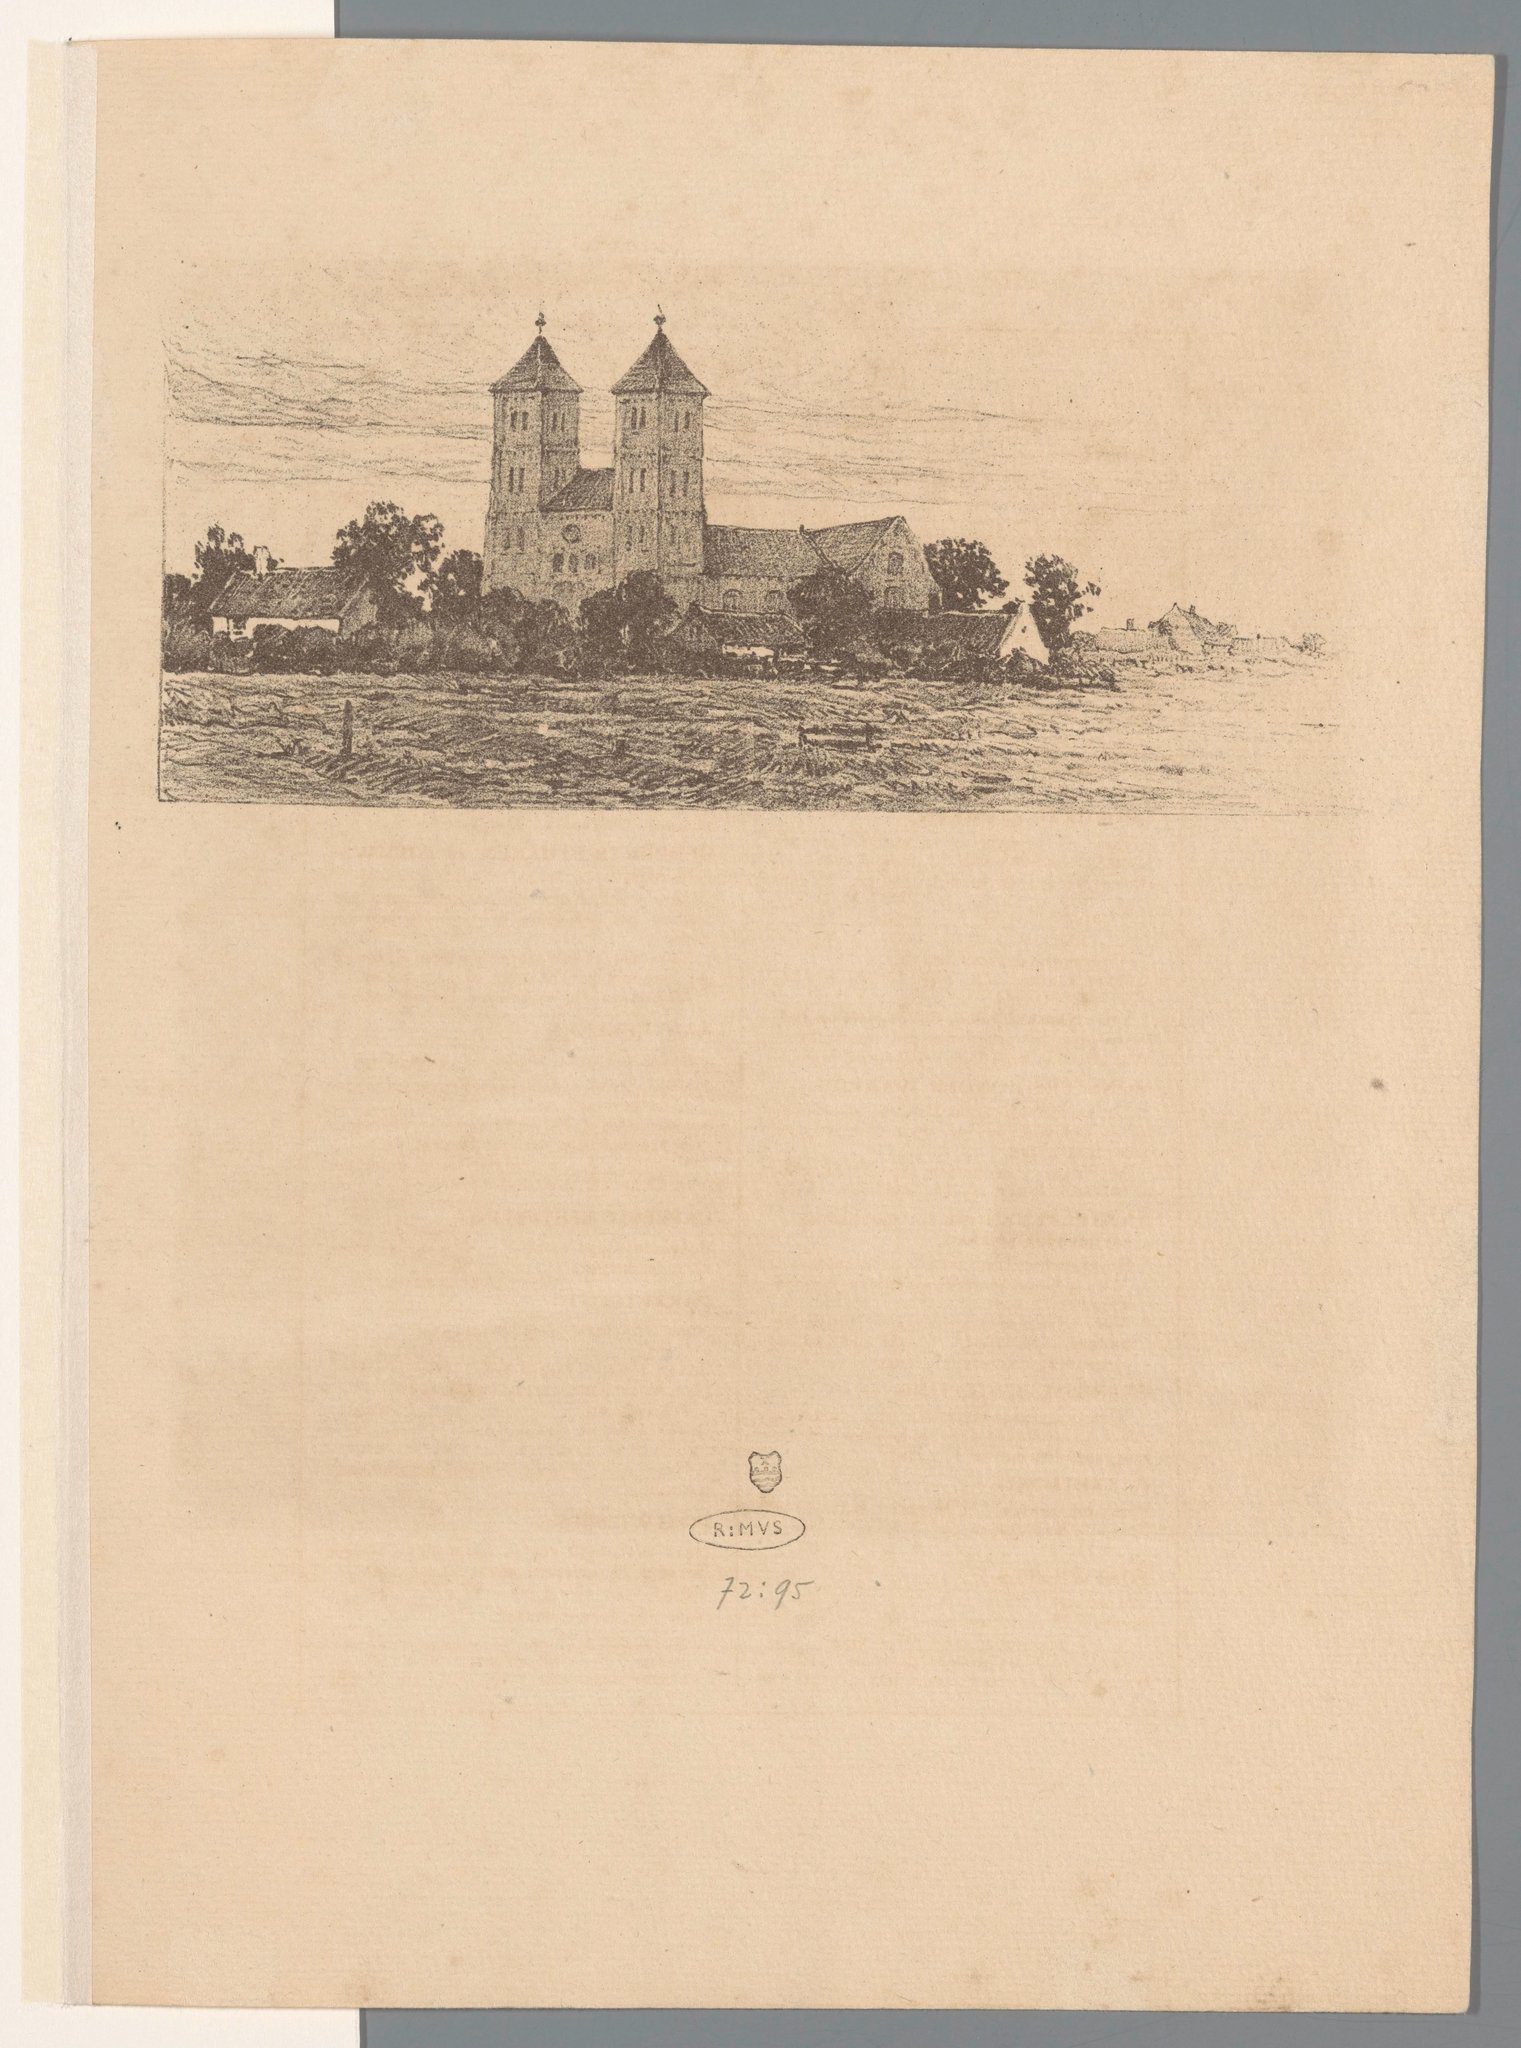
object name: print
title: Gezicht op dorp met kerk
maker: simon moulijn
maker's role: draughtsman, print maker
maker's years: 1866-1948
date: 1876-1948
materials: paper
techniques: lithograph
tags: prospect of village, silhouette of village, church (exterior)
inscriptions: collector's mark: Lugt 2760, collector's mark: Lugt 2228